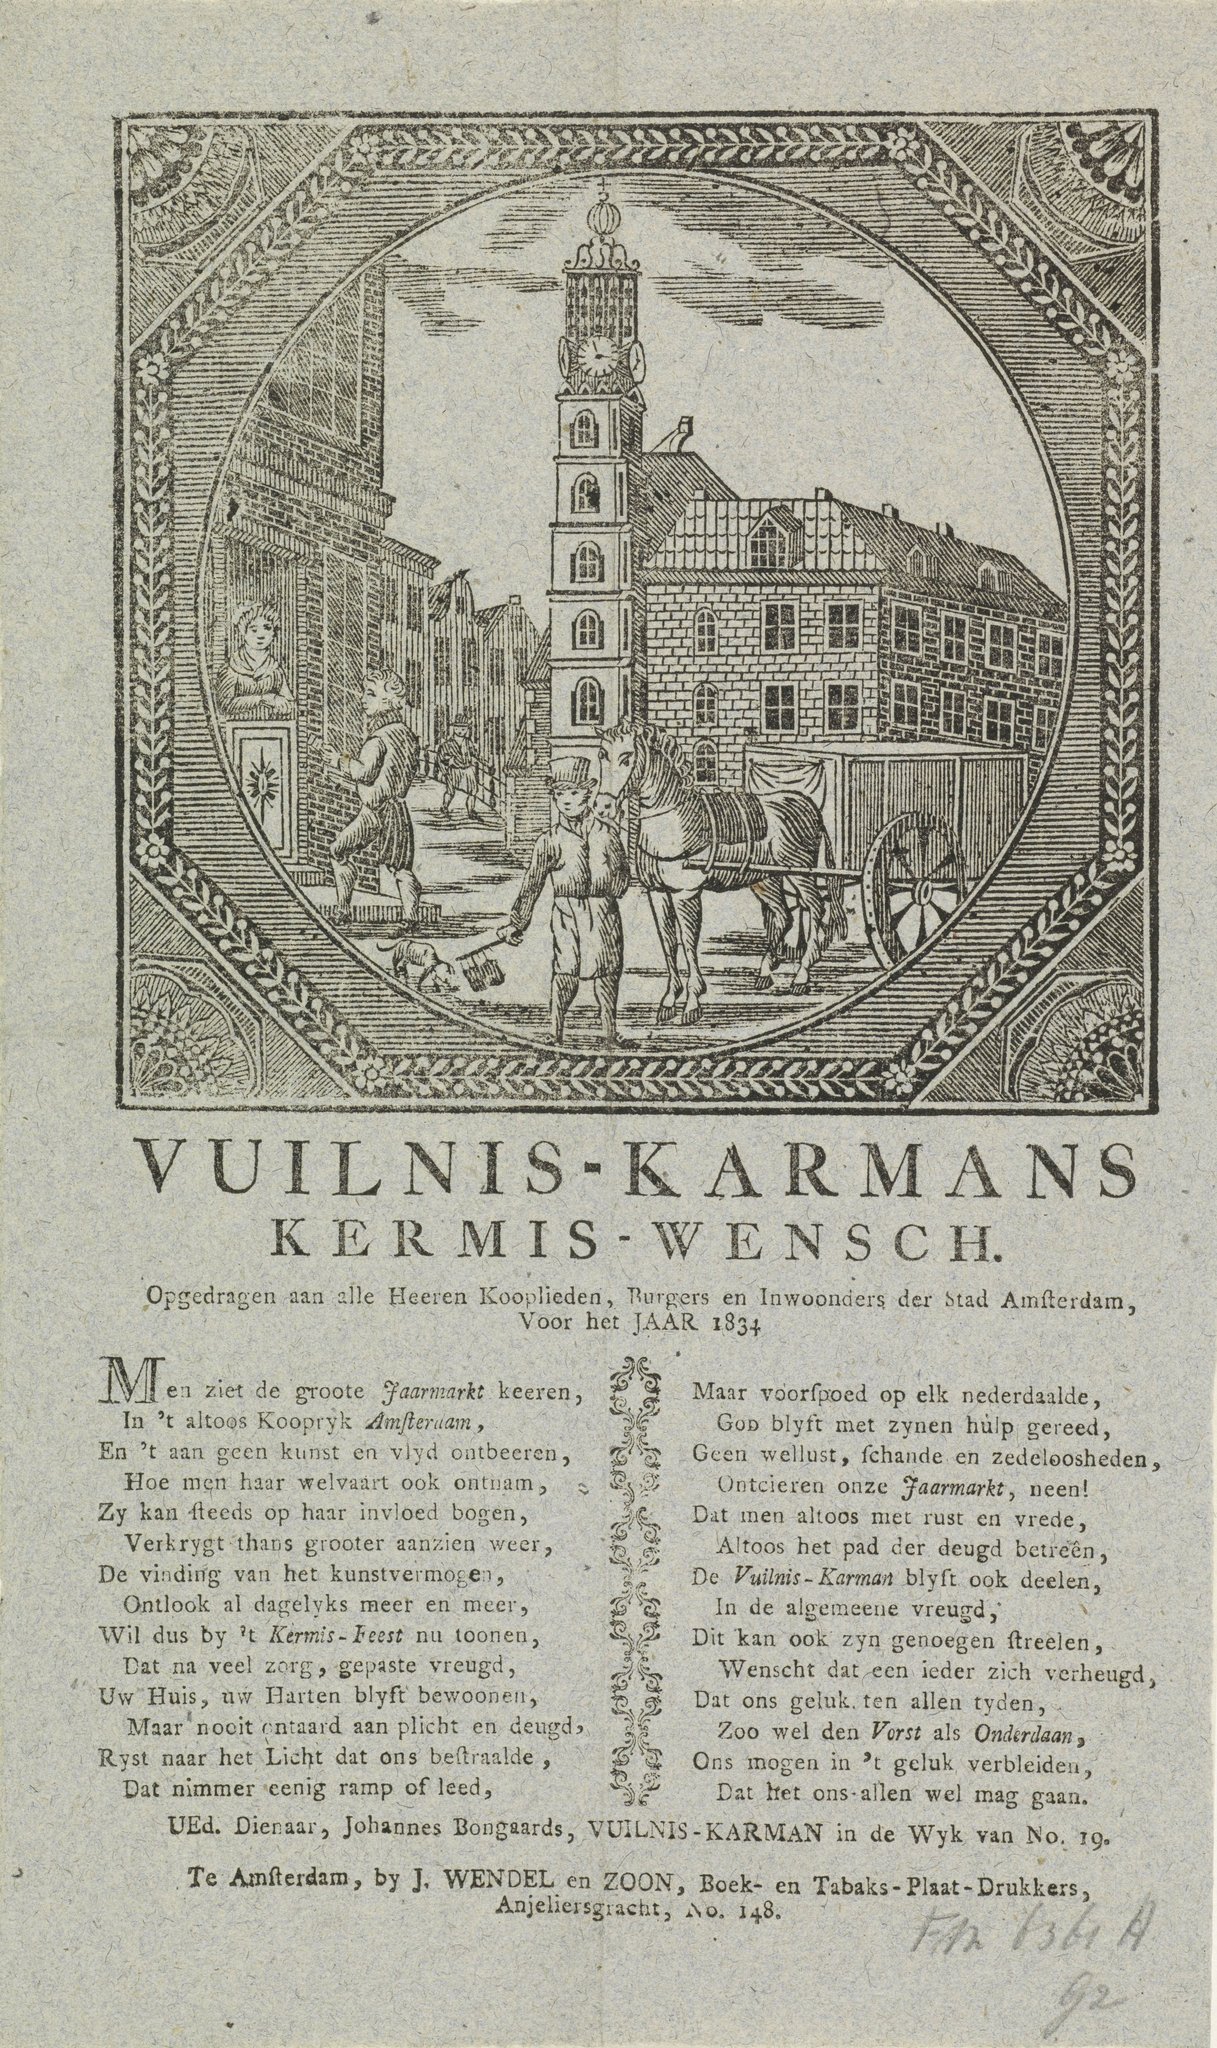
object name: print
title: Kermisprent van de vuilnismannen van Amsterdam voor het jaar 1834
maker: Anonymous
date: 1834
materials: paper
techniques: letterpress printing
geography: amsterdam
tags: street, garbage collection, amsterdam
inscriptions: collector's mark: Lugt 2228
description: Kermisprent van de Amsterdamse vuilnismannen voor het jaar 1834. Ronde voorstelling binnen achtkantige rand met een gezicht bij de Munt te Amsterdam waar een man met een ratel bij een vuilniskar staat. Een andere man haalt bij een huis geld op. Met gedicht in twee kolommen. Van de vuilniskarman in de wijk no. 19: Johannes Bongaards.